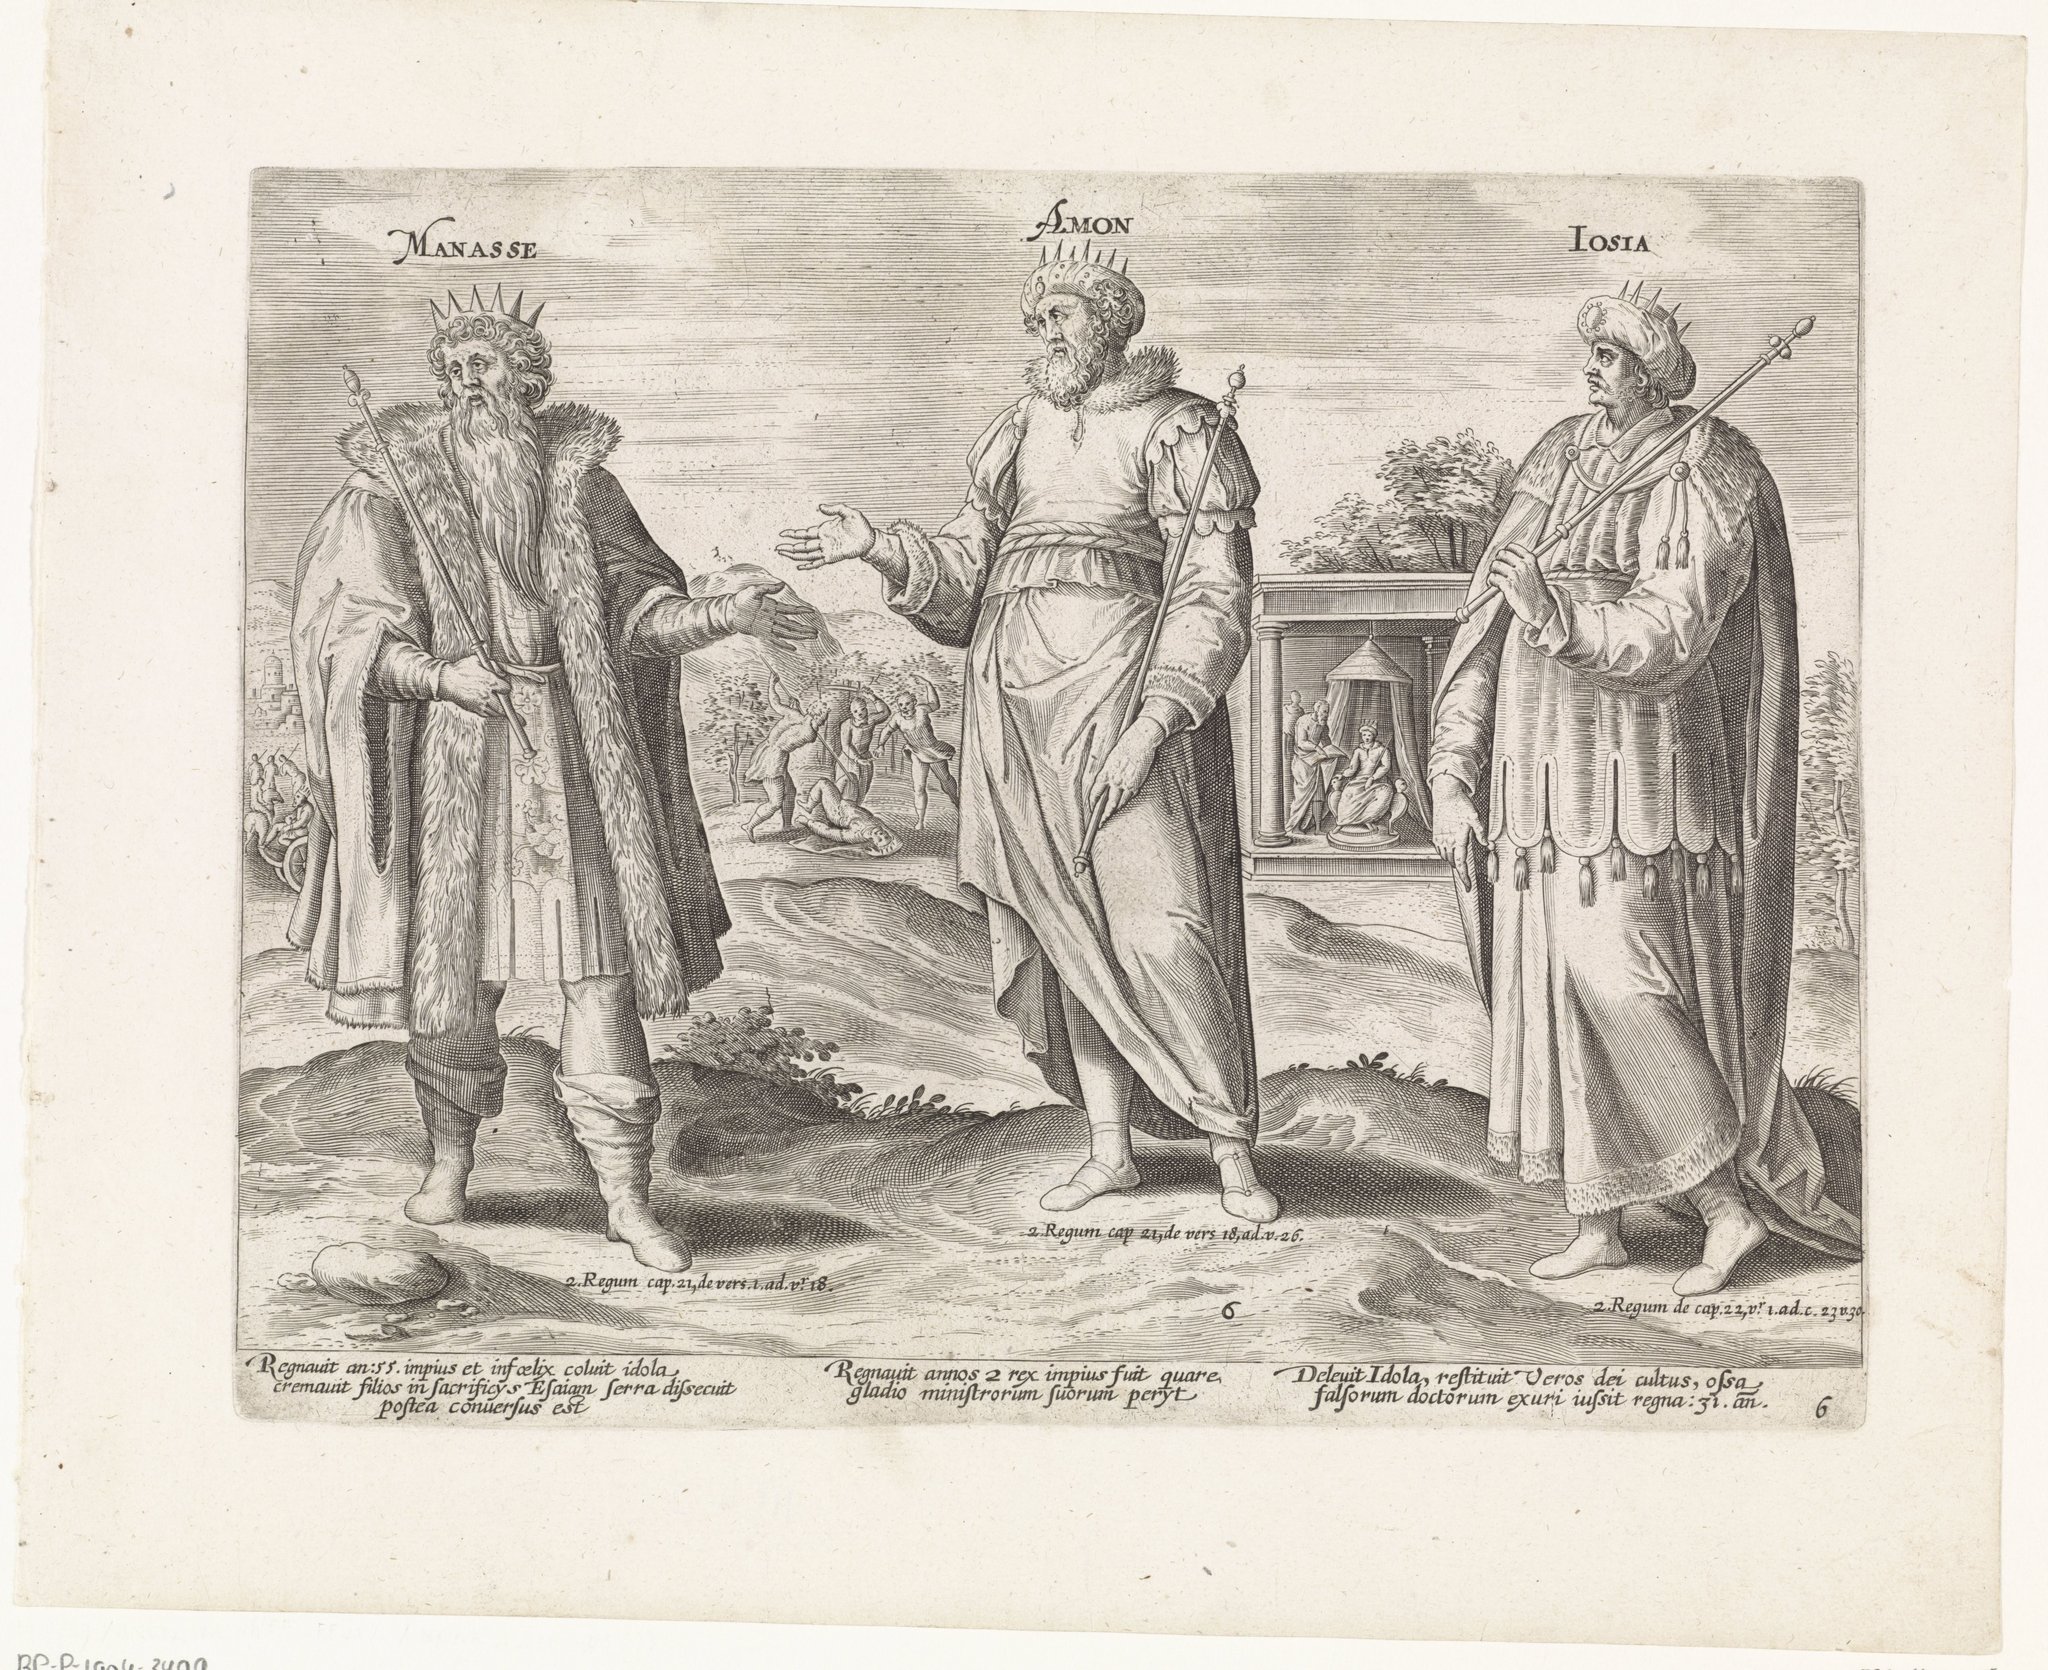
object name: print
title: Theatrum biblicum (...)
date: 1585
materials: paper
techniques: engraving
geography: amsterdam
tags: story of manasseh, son of hezekiah, king of judah (2 kings 21:1-18; 2 chronicles 33:1-20), amon is killed in his palace (+ variant), story of josiah, son of amon, king of judah (2 kings 22:1 - 23:30; 2 chronicles 34-35), story of amon, son of manasseh, king of judah (2 kings 21:19-26; 2 chronicles 33:21-25), saphan reads the book of law aloud to the king who tears his clothes in dismay, kings of israel and judah ~ the old testament (not in biblical context)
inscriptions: collector's mark: Lugt 2228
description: De koningen Manasse, Amon en Josia. Op de achtergrond enkele belangrijke gebeurtenissen uit hun leven. Links op de achtergrond zit koning Manasse in zijn strijdwagen. Midden op de achtergrond de moord op Amon door zijn eigen dienaren. Rechts op de achtergrond laat koning Josia zich voorlezen uit een boekrol die in de tempel werd gevonden. Onder de voorstelling verwijzingen naar de Bijbelteksten in het Latijn.